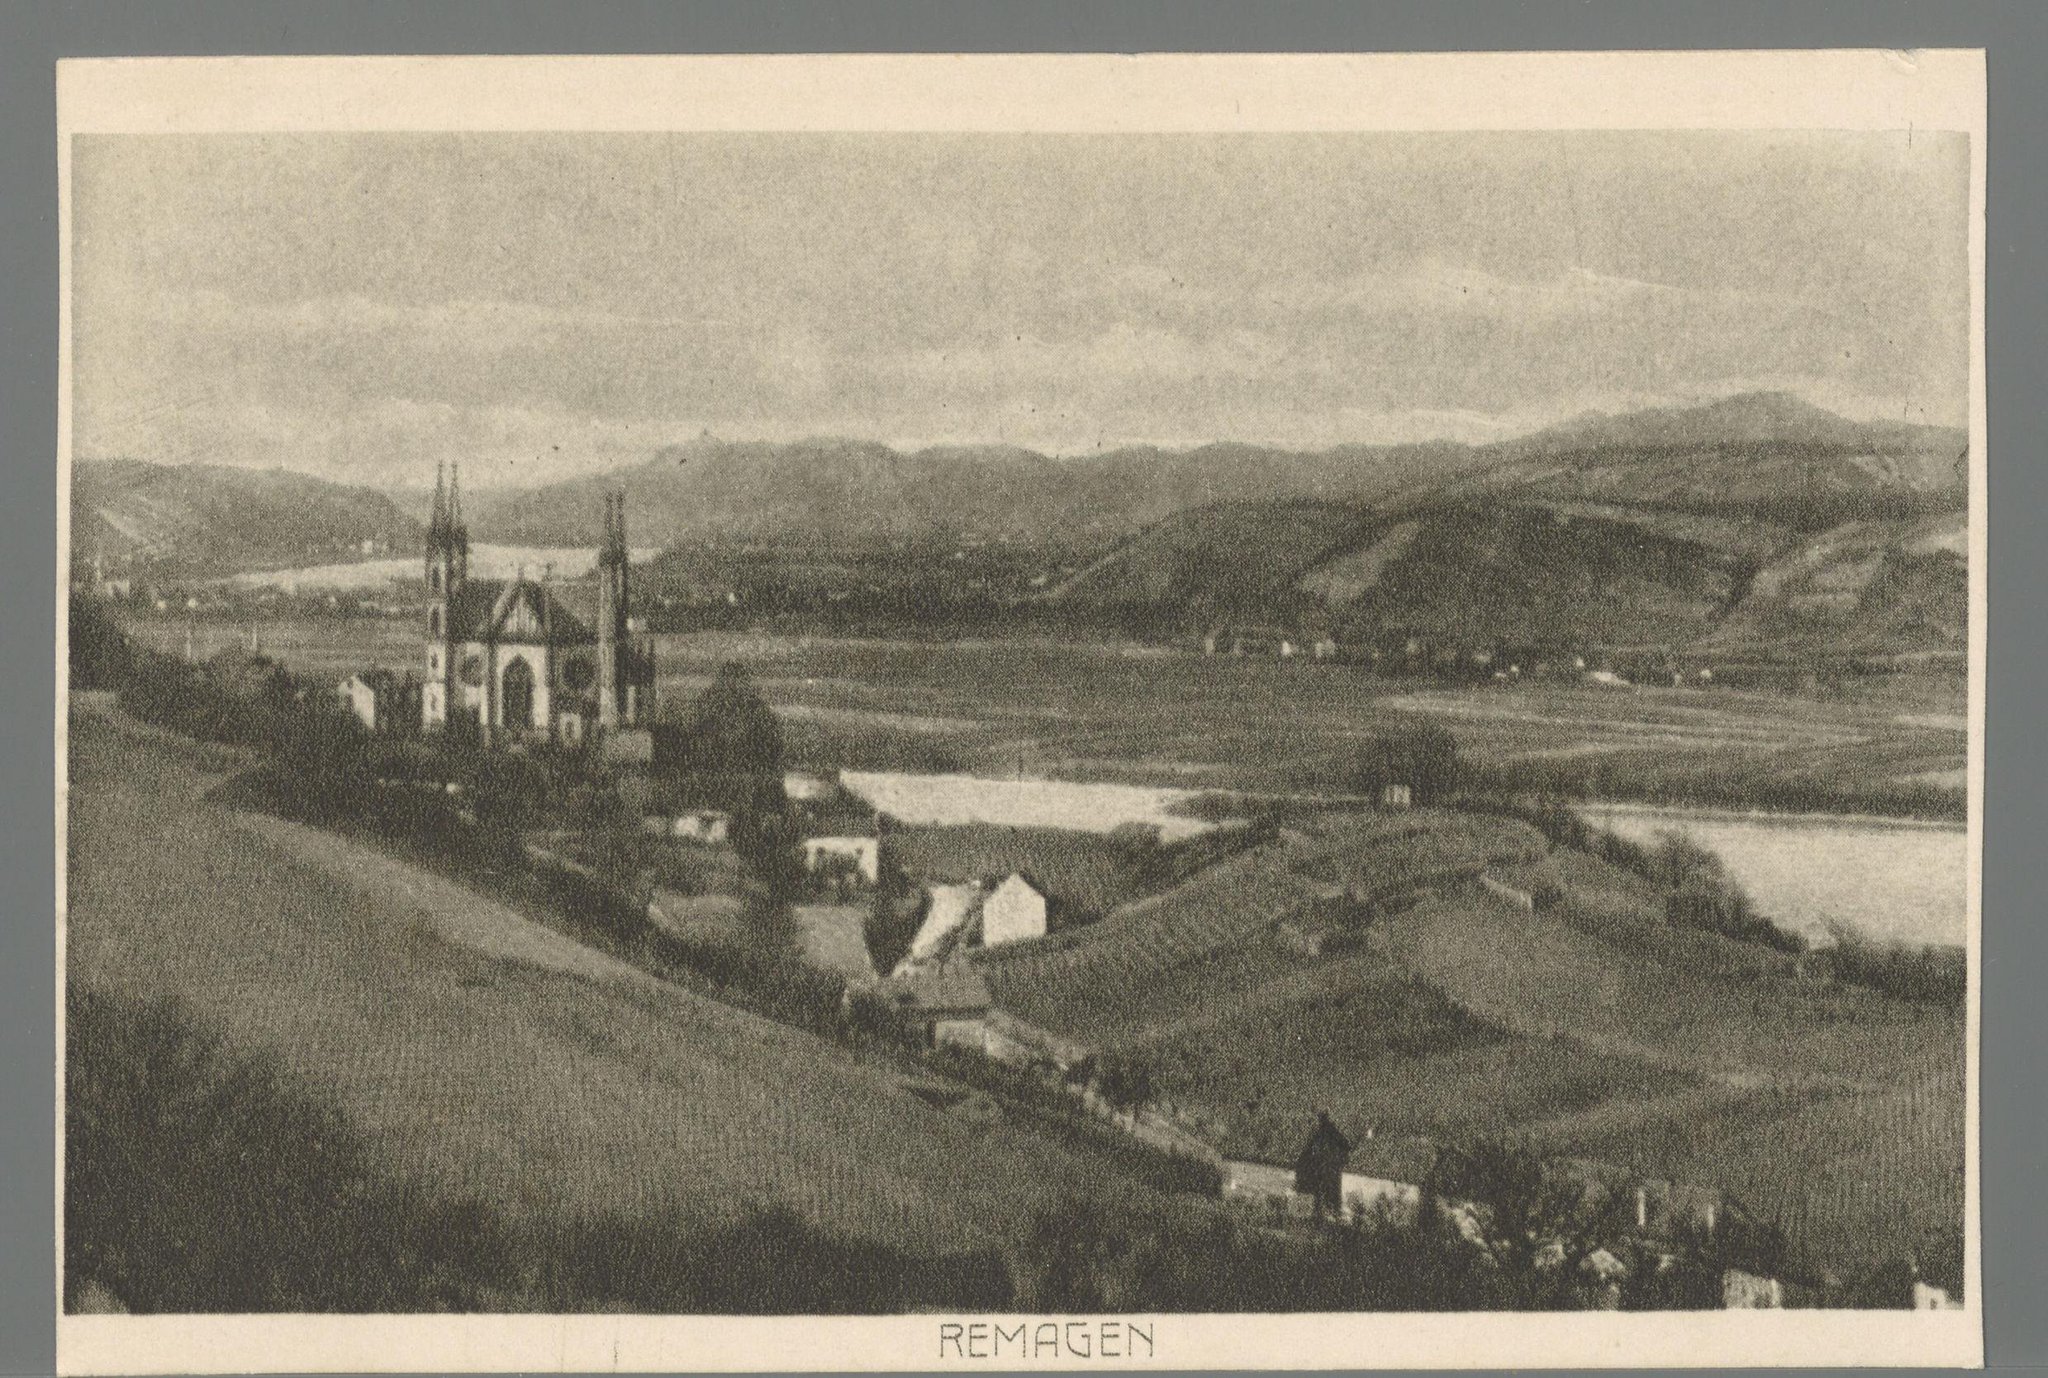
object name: photomechanical print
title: Remagen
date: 1905-1930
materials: cardboard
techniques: rotogravure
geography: siegburg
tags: river, church (exterior), mountains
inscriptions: monogram: ‘K.T.F.’